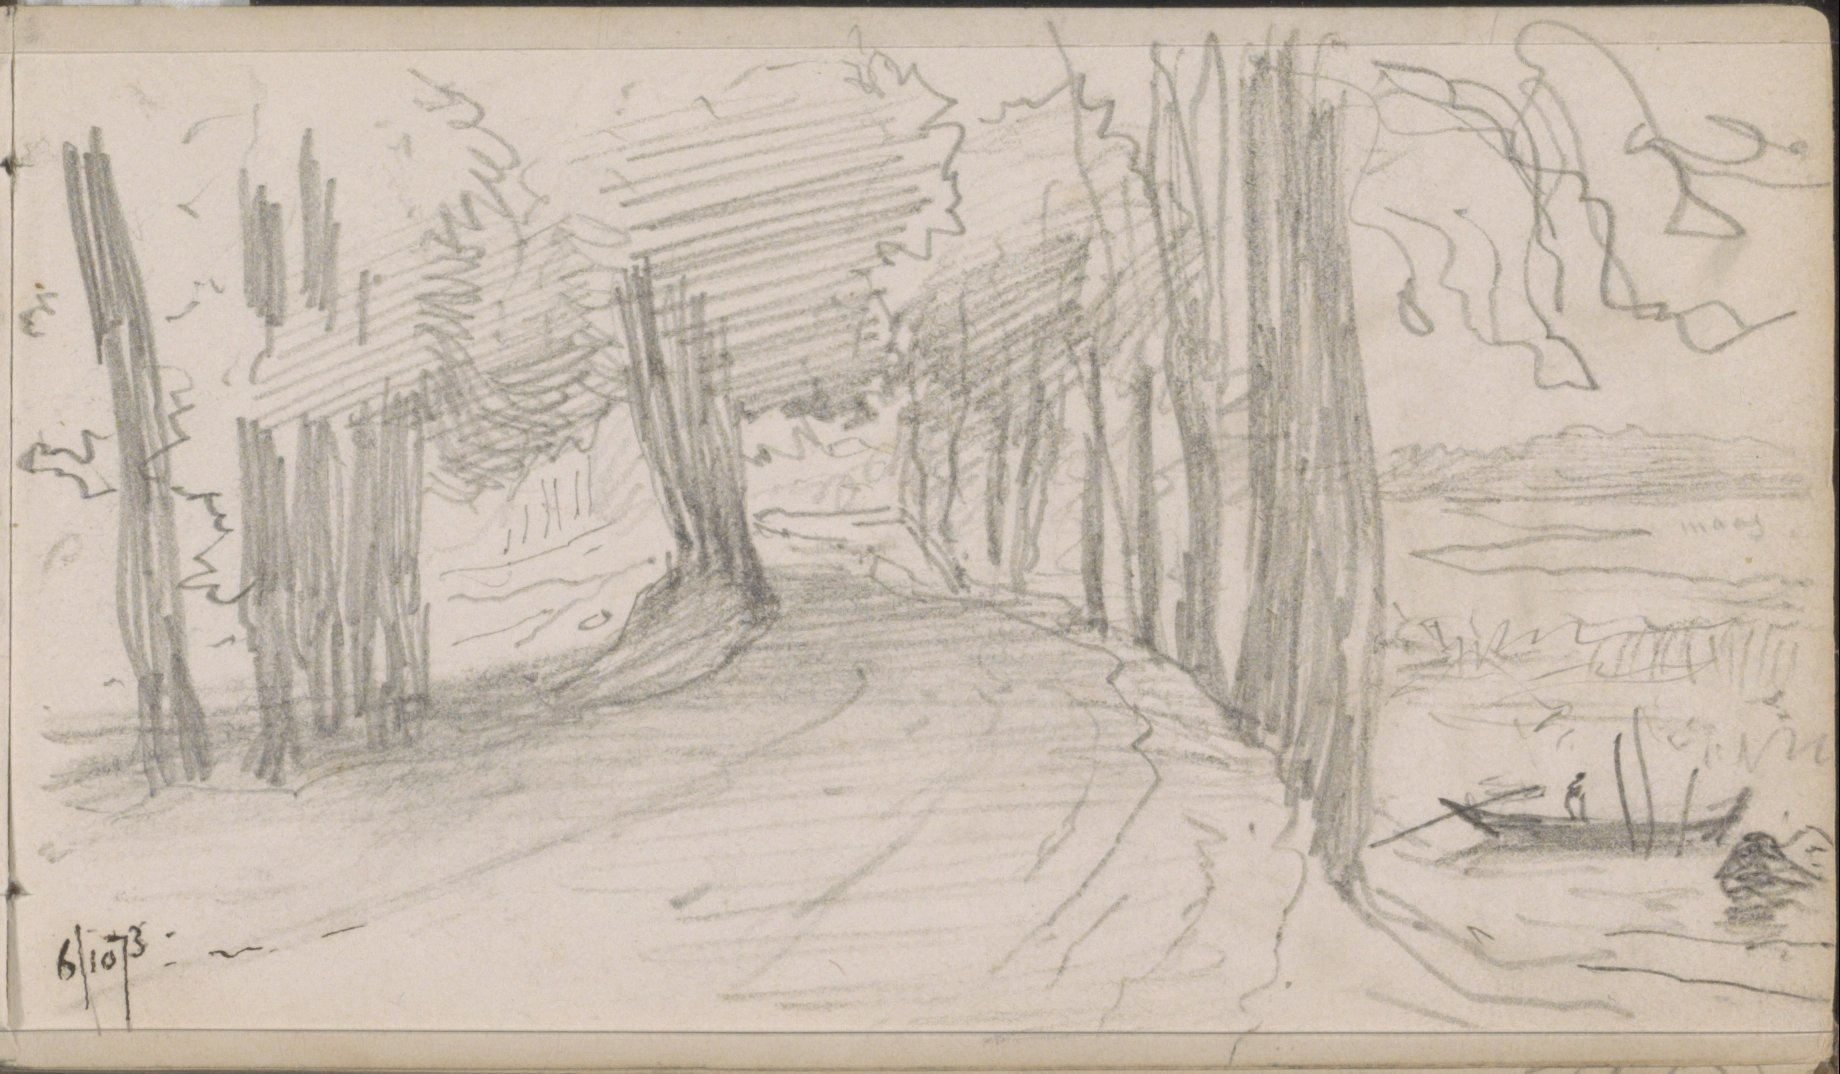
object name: sketchbook leaf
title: Laan met bomen op de dijk bij Katendrecht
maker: johannes tavenraat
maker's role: draughtsman, painter, print maker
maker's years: 1809-1881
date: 1810-1873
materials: paper, pencil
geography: katendrecht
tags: trees, rowing-boat, canoe, etc., road, path, dikes, levee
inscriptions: date: ‘6/10 73’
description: Op het water een figuur in een roeiboot. Blad 3 recto uit een schetsboek met 46 bladen.